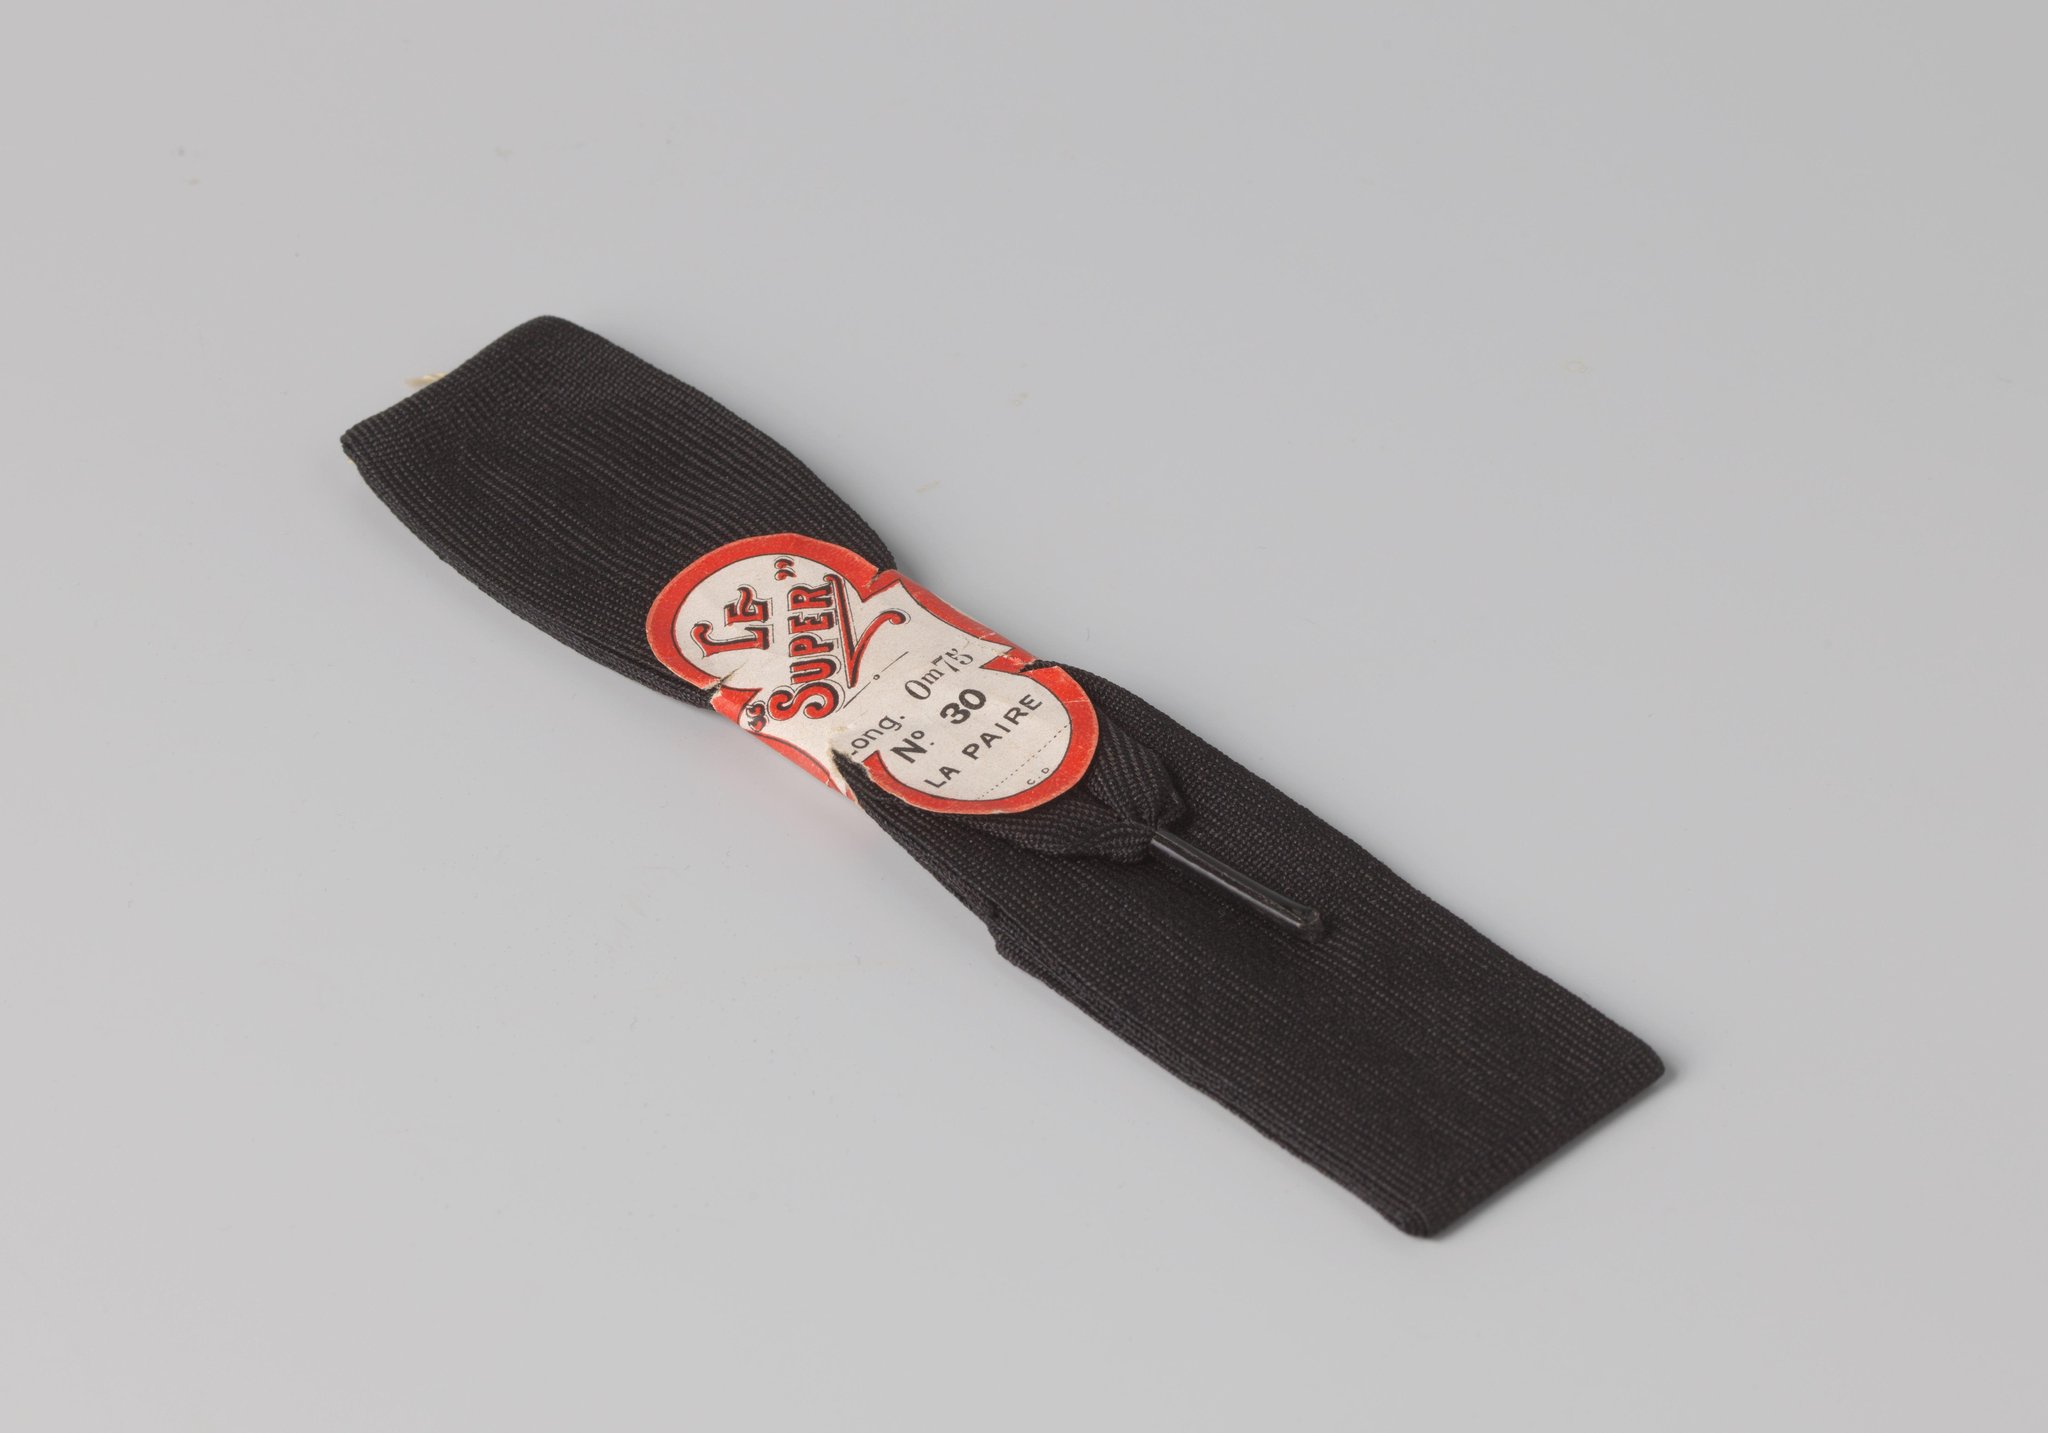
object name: clothing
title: Paar (?) veters van grijsblauwe polyester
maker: Anonymous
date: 1945-1965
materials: metal, plastic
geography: western europe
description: Paar (?) veters van grijsblauwe polyester met licht ingeweven argile ruit, ongebruikt, in orginele verpakking.